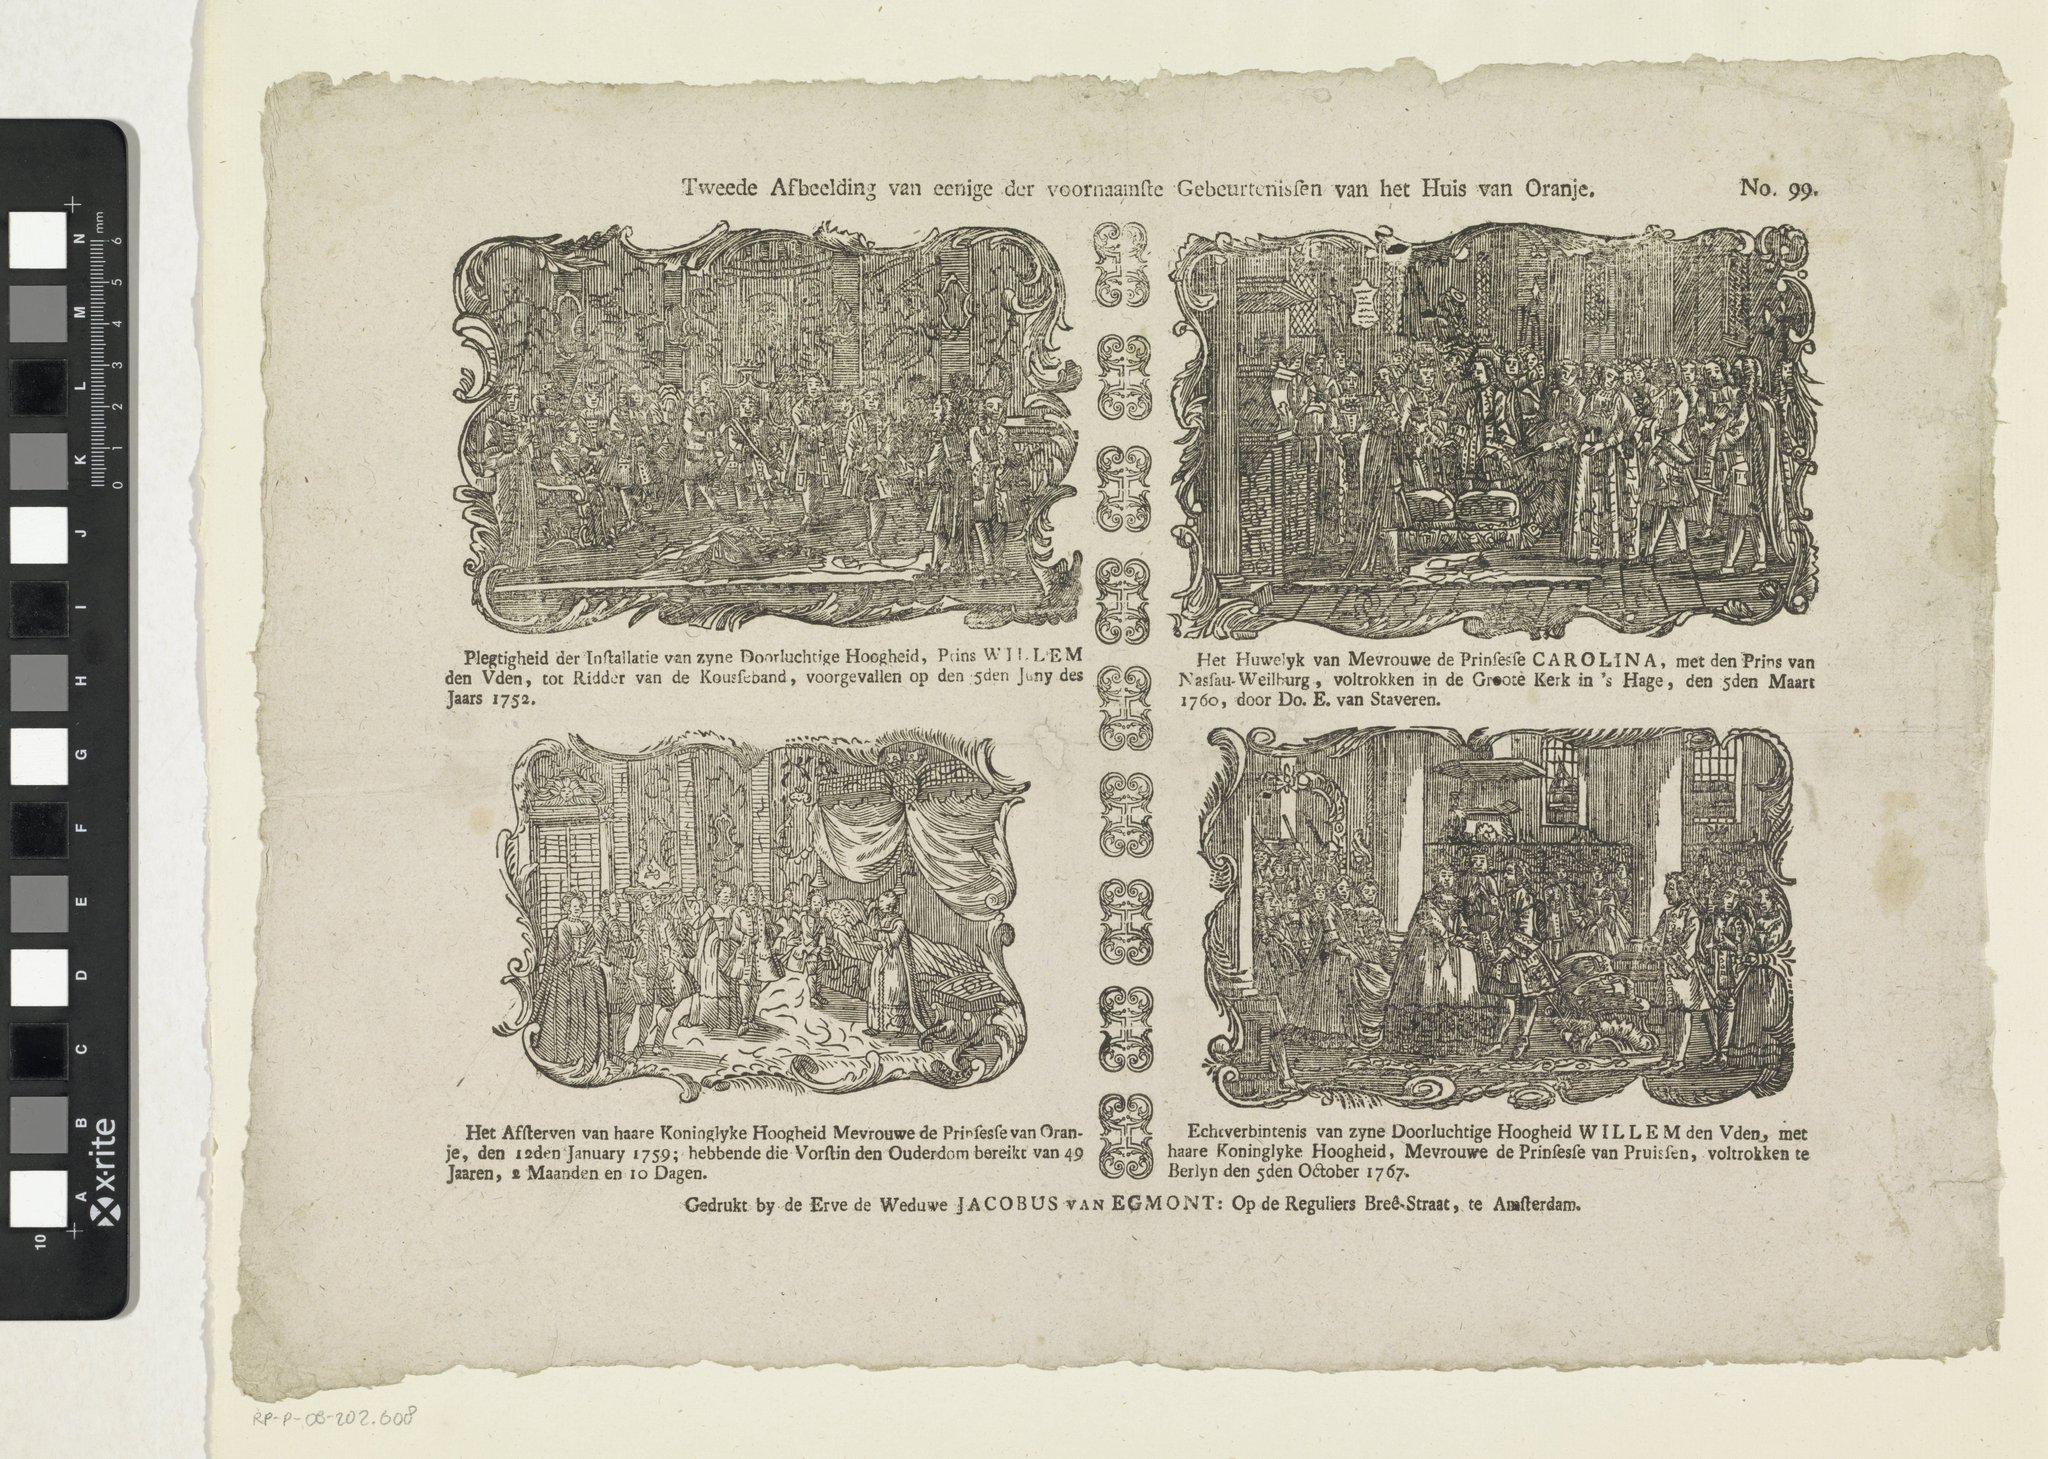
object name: popular print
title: Tweede afbeelding van eenige der voornaamste gebeurtenissen van het Huis van Oranje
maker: Anonymous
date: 1761-1804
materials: paper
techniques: letterpress printing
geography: amsterdam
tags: william v (prince of orange), carolina (prinses van oranje-nassau), anna van hannover, karel christiaan vorst van nassau-weilburg, berlin, the hague, wilhelmina frederica louisa (koningin der nederlanden)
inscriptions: collector's mark: Lugt 2760